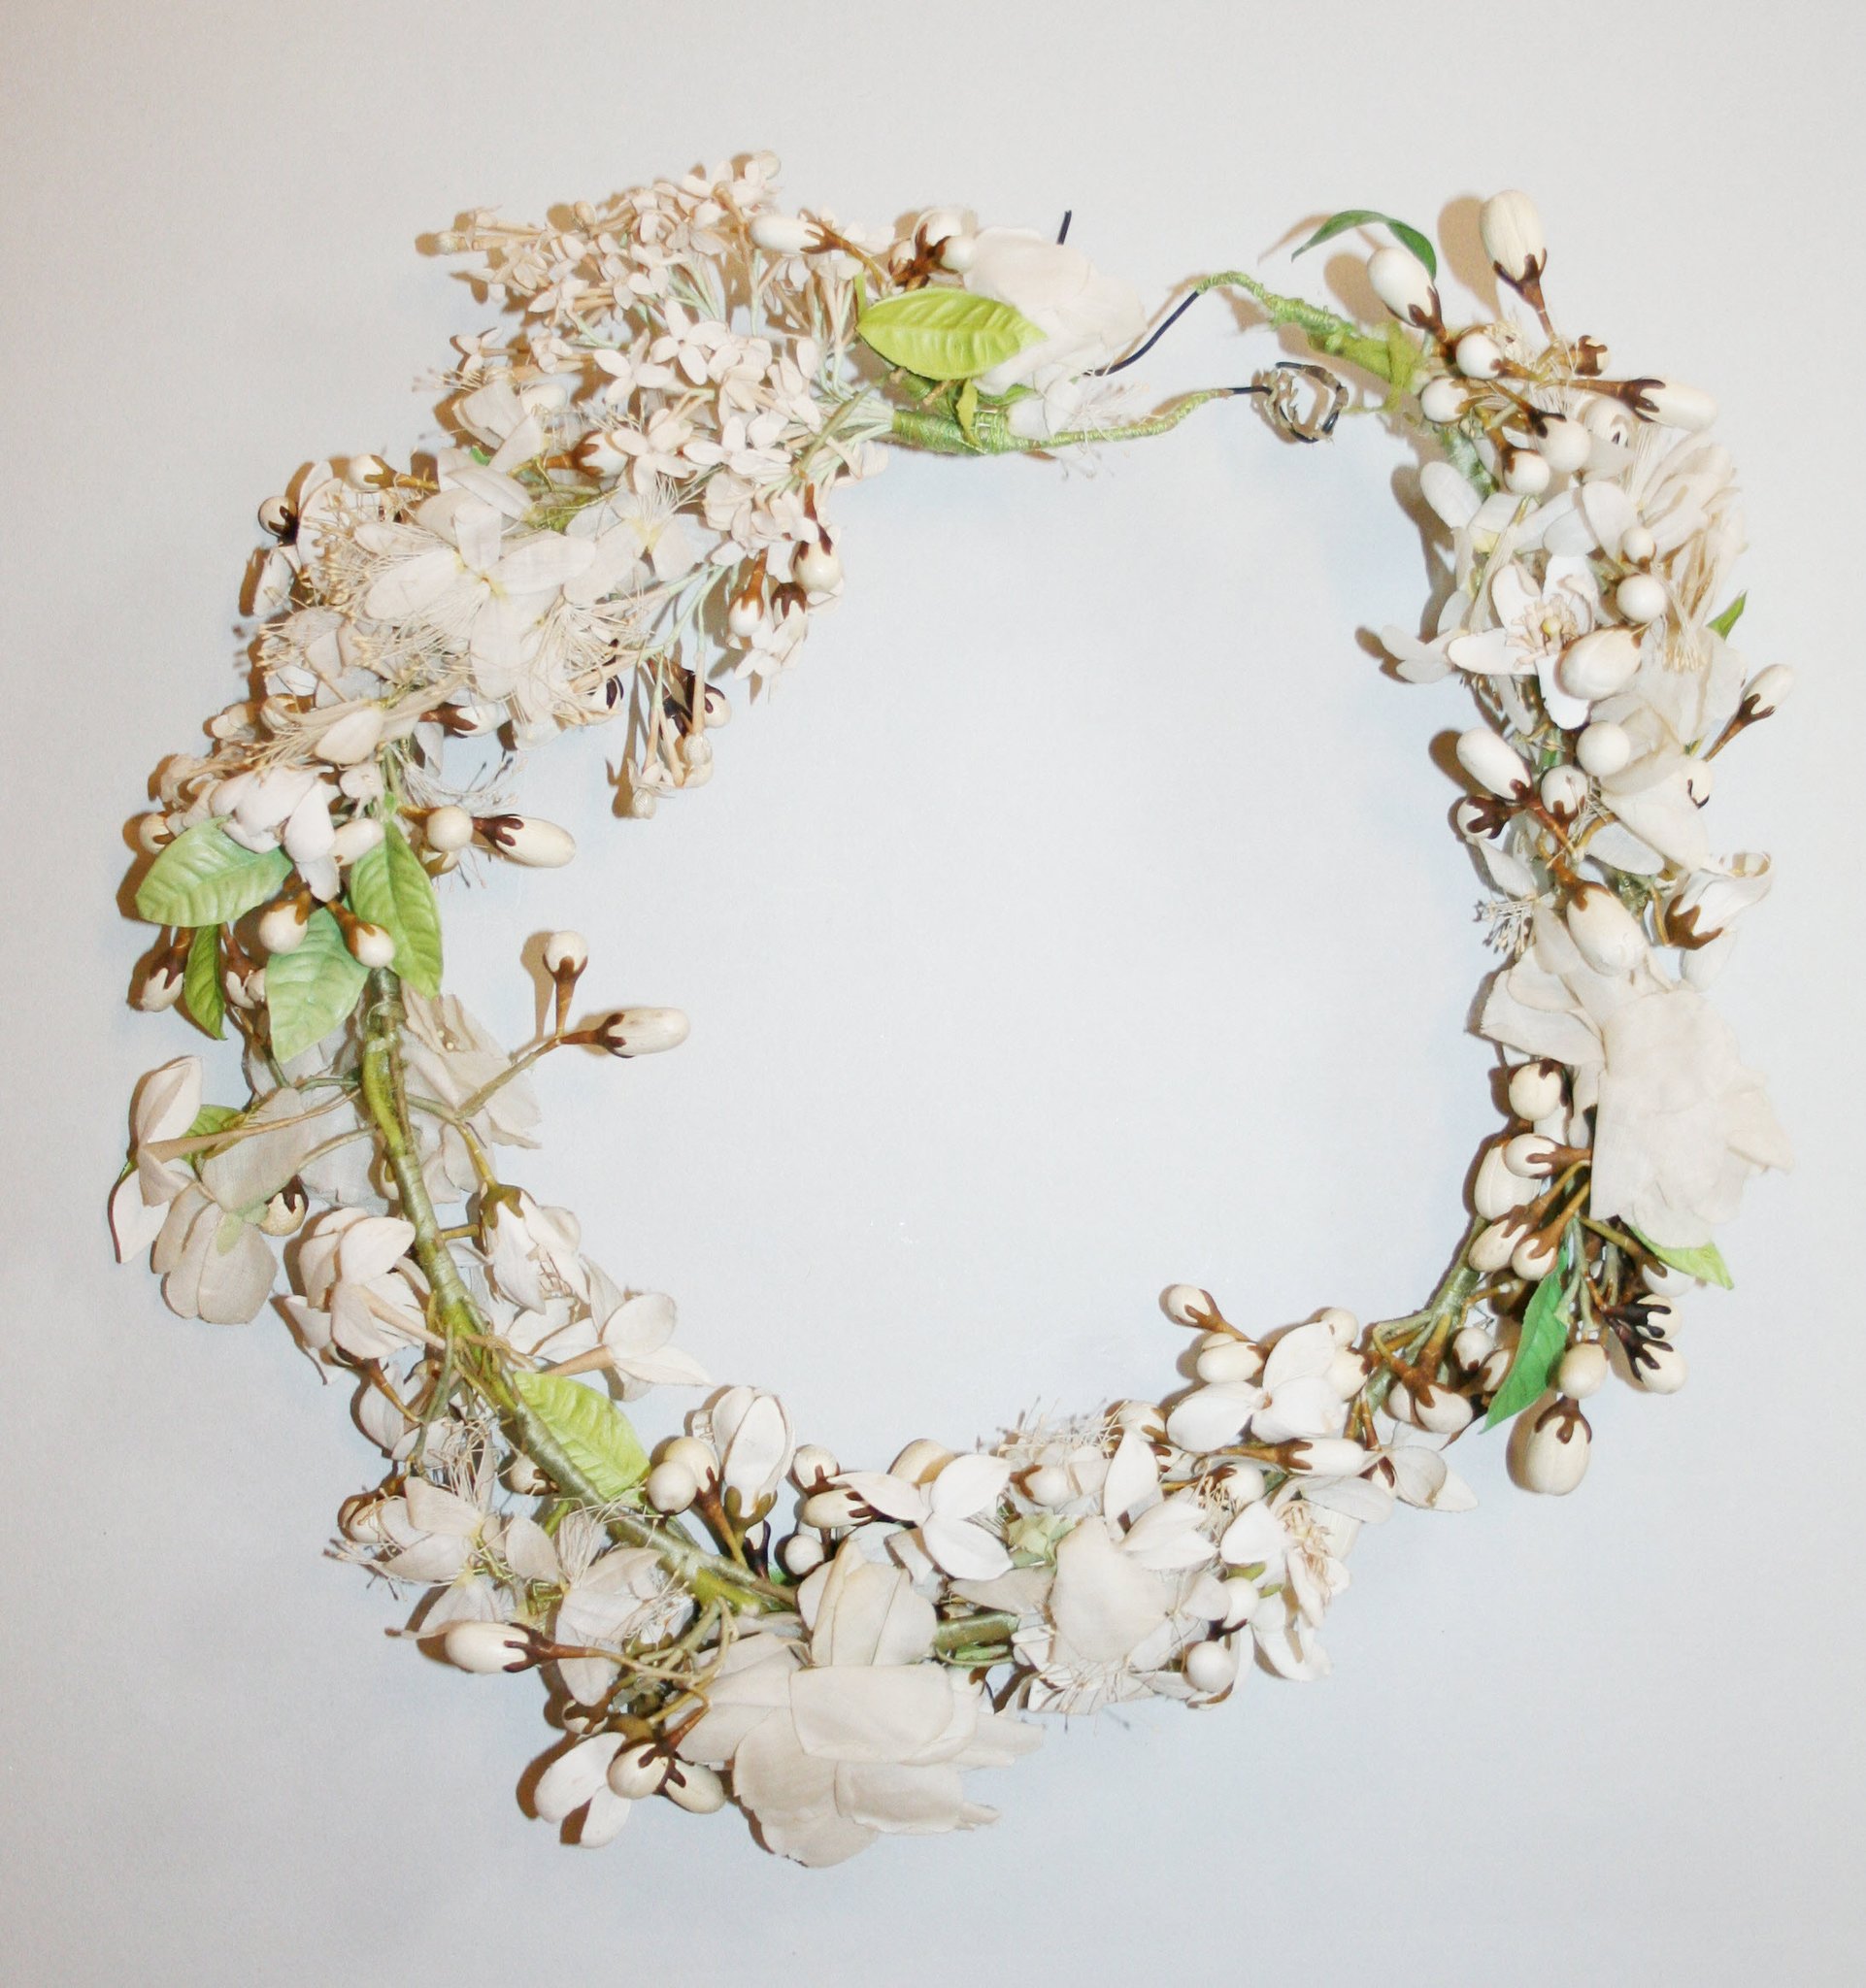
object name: wedding headdress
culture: american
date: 1834-1866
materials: metal, silk